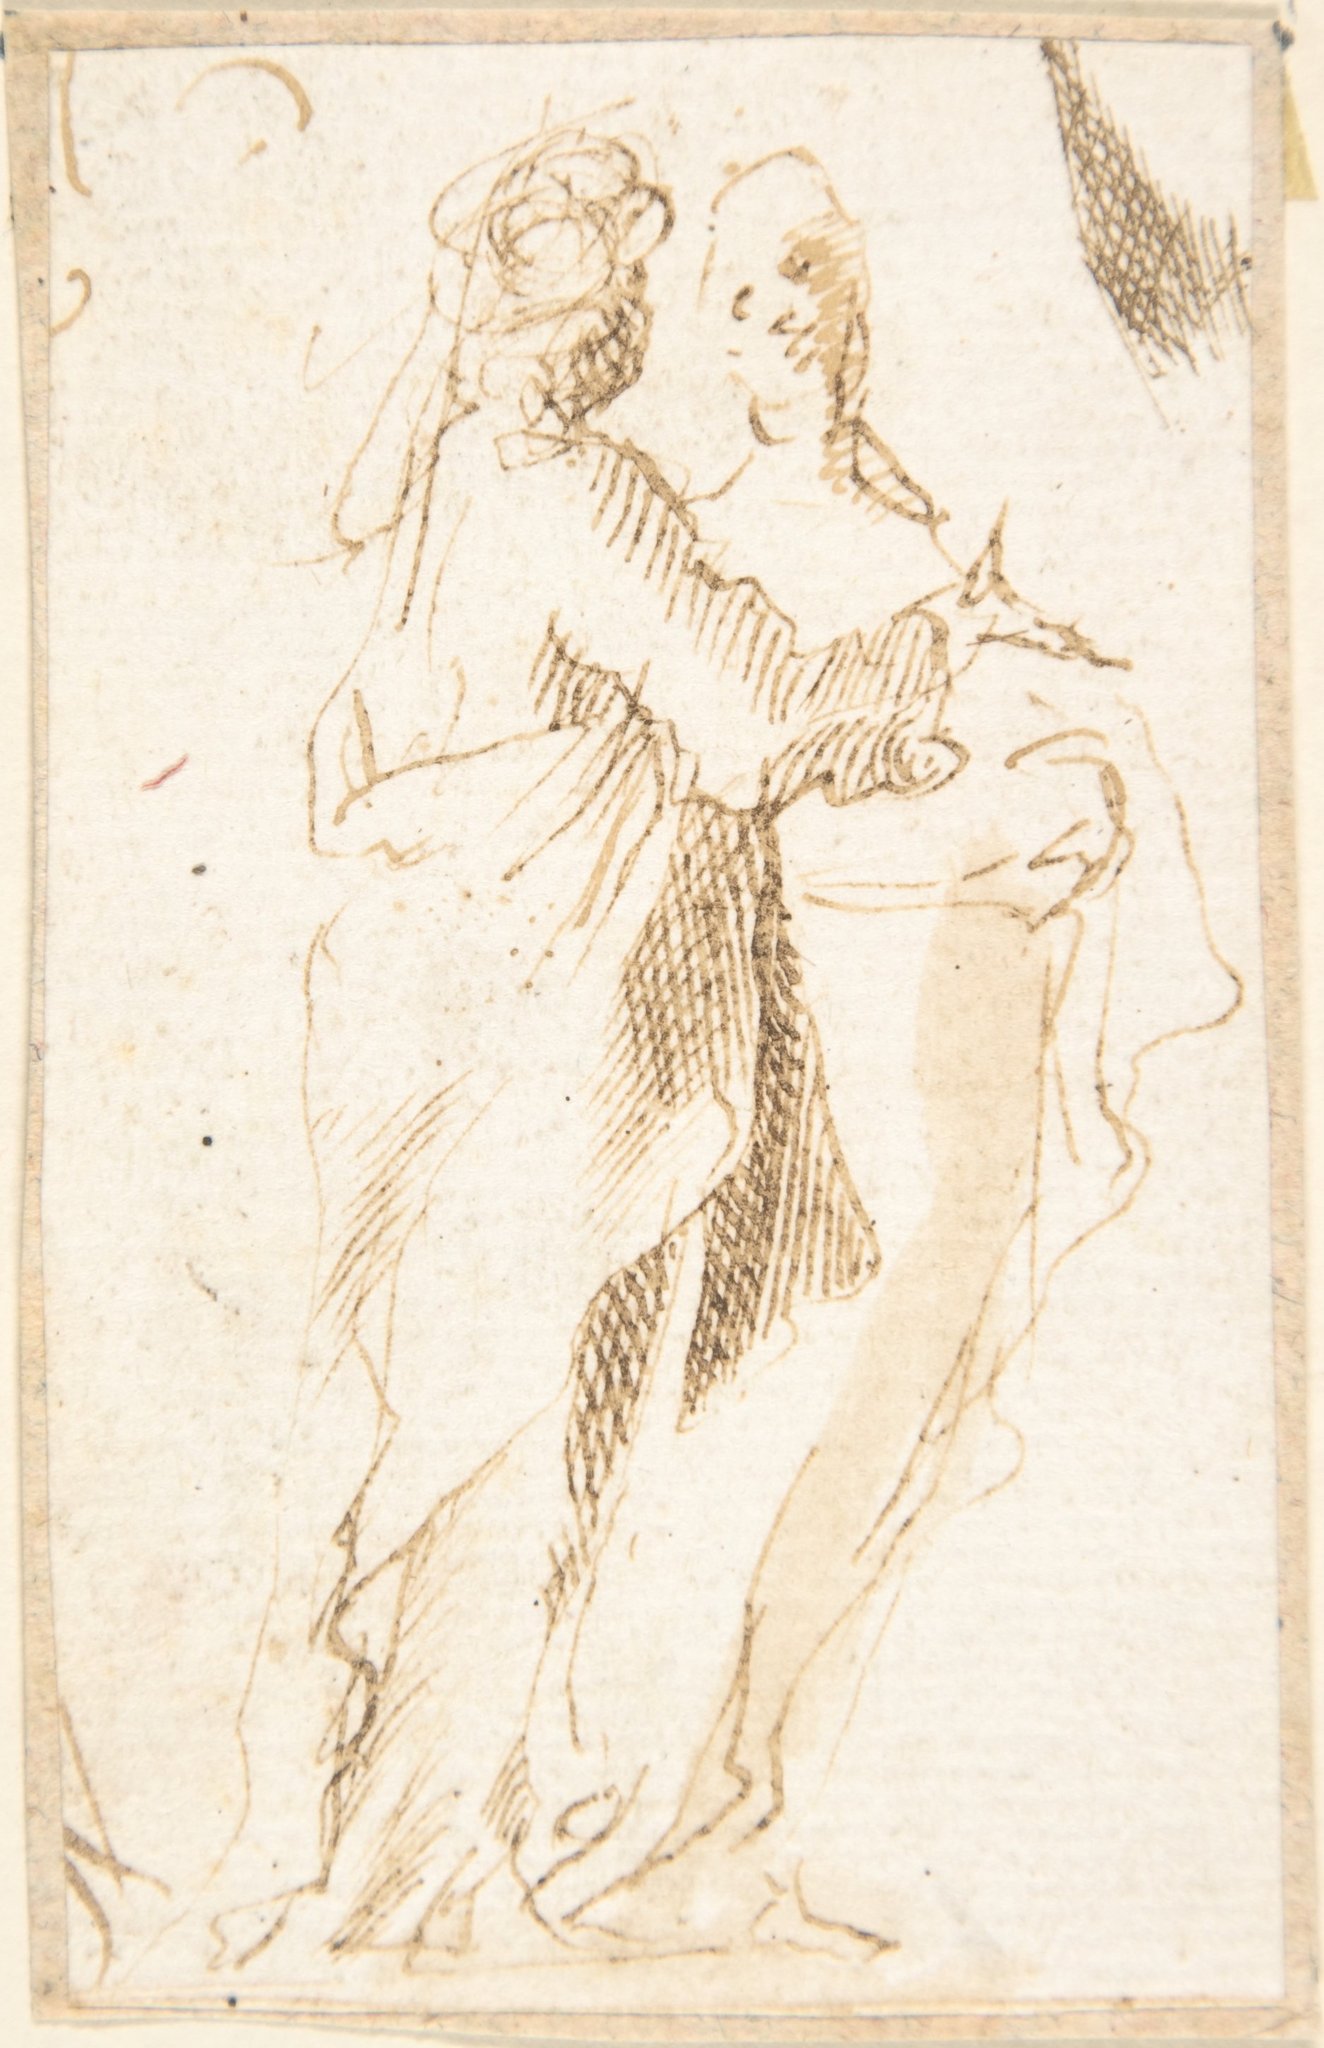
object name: drawing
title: Two Standing Figures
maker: anonymous, spanish, school of seville, 17th century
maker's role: artist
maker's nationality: spanish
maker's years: 1600-1700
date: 1601-1700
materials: ink, ivory, paper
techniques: brush, pen, wash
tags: human figures